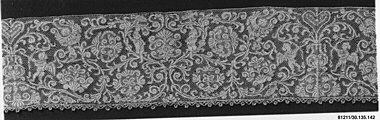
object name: border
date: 1675-1700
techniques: lace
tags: putti